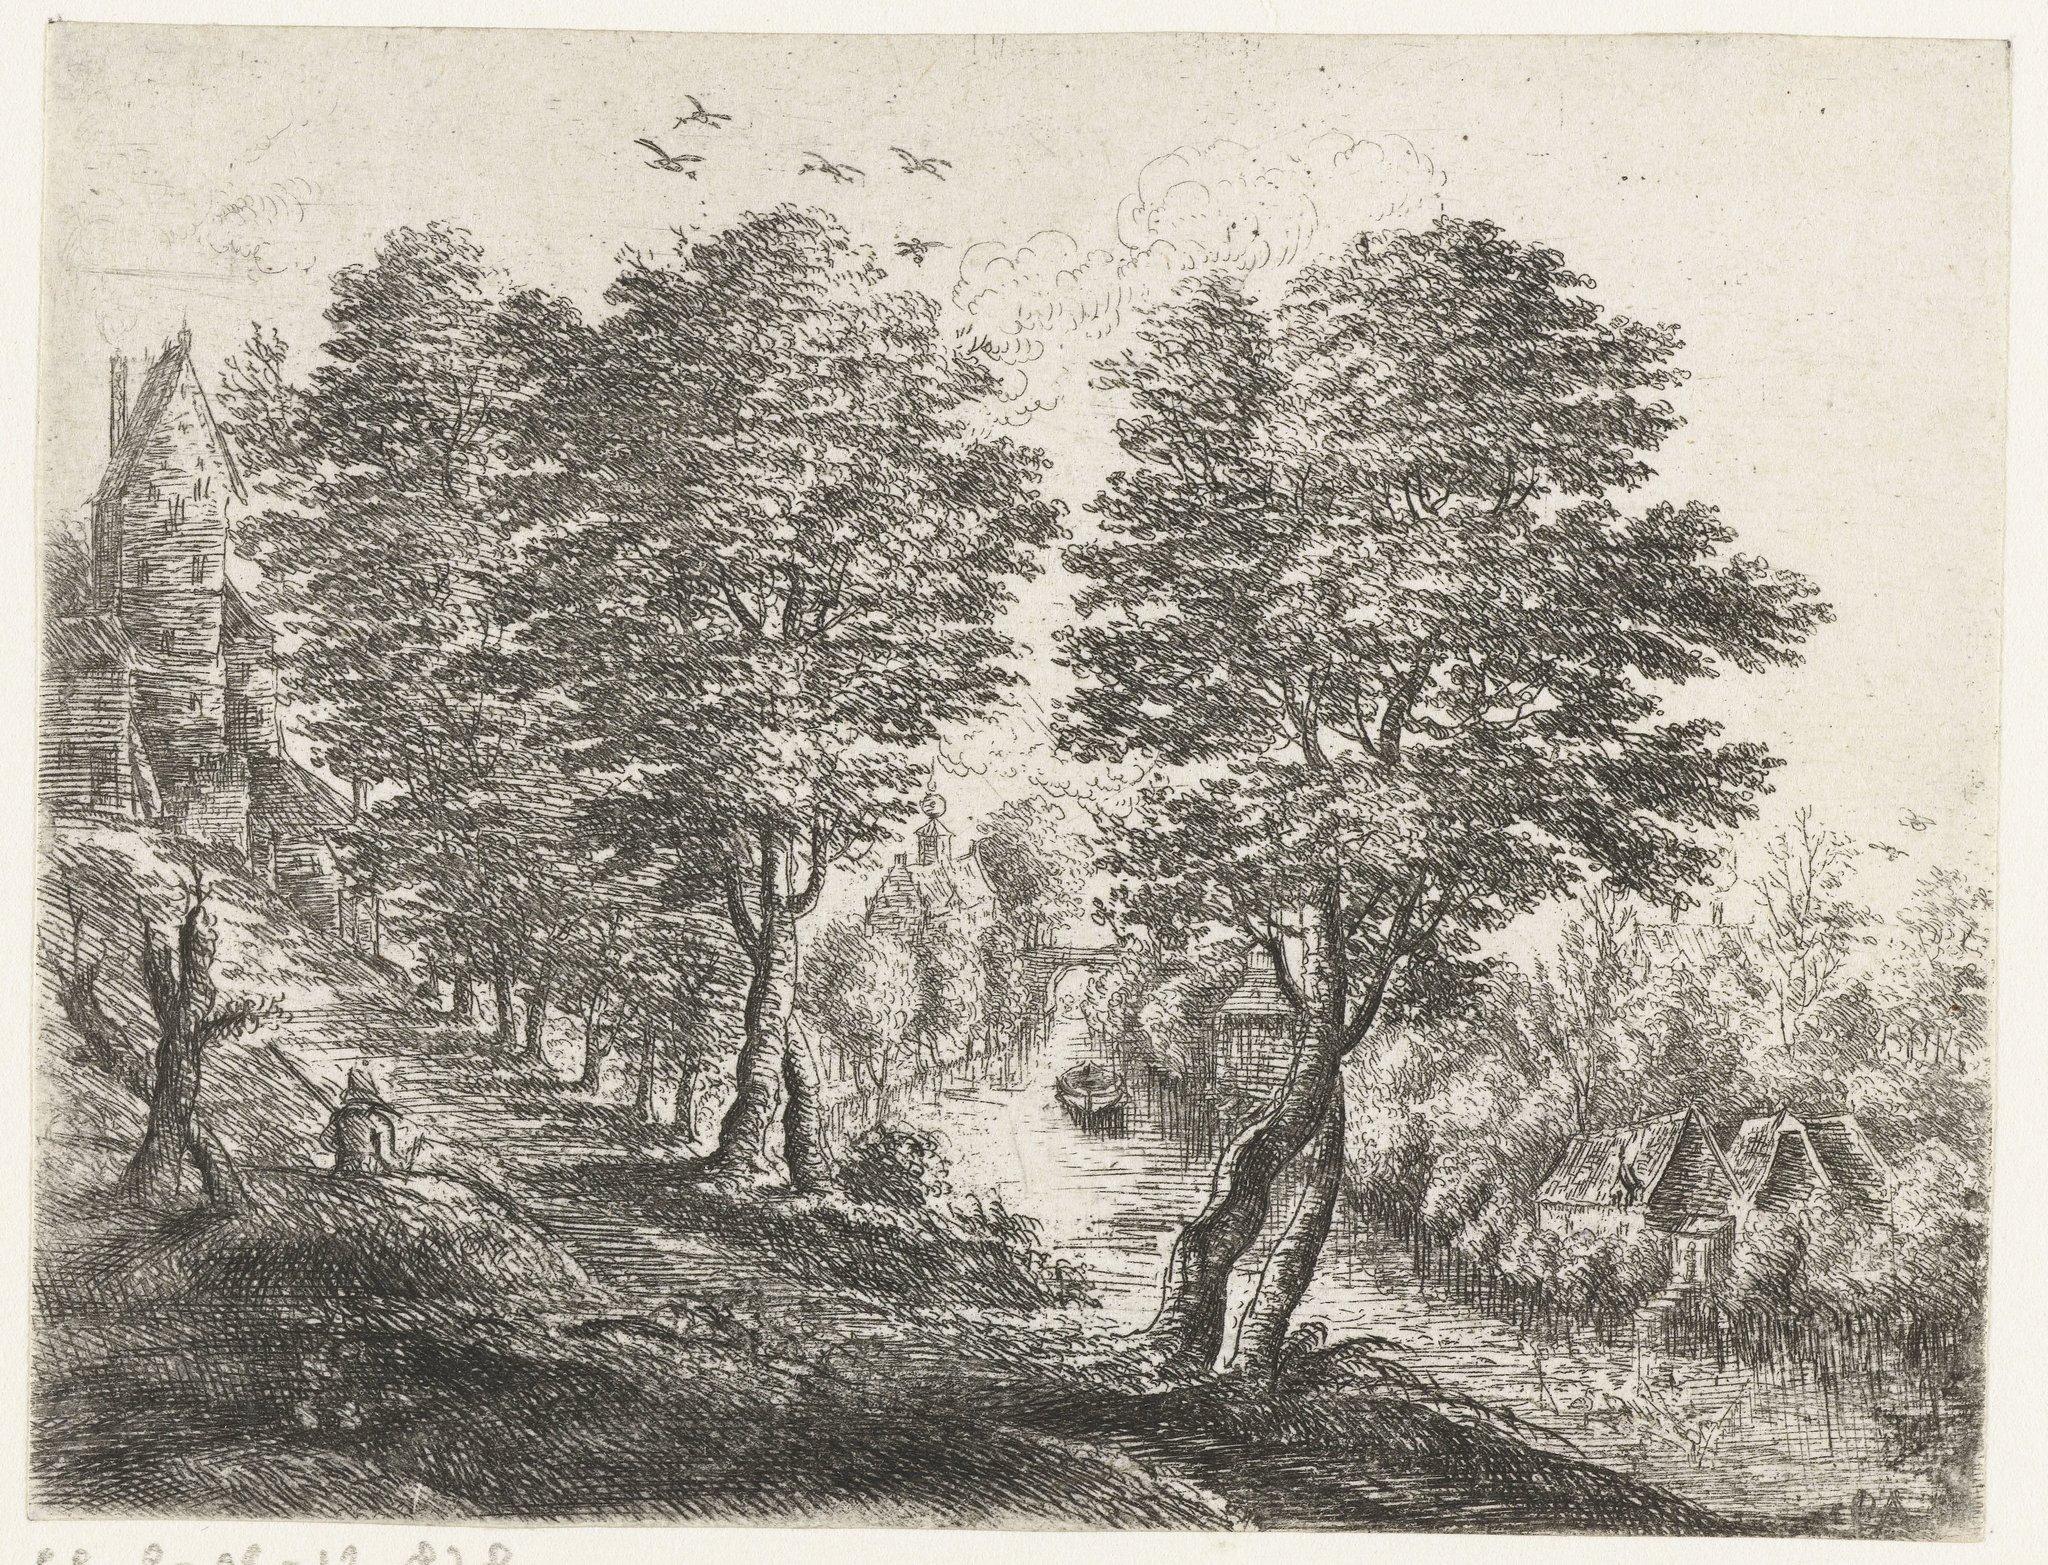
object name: print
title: Acht landschappen naar Lucas van Uden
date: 1637-1679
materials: paper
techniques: engraving, etching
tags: river, farmers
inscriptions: collector's mark: Lugt 240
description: Tweede uit een serie van acht. Landschap met huizen lang een rivier, en een zittende boer.